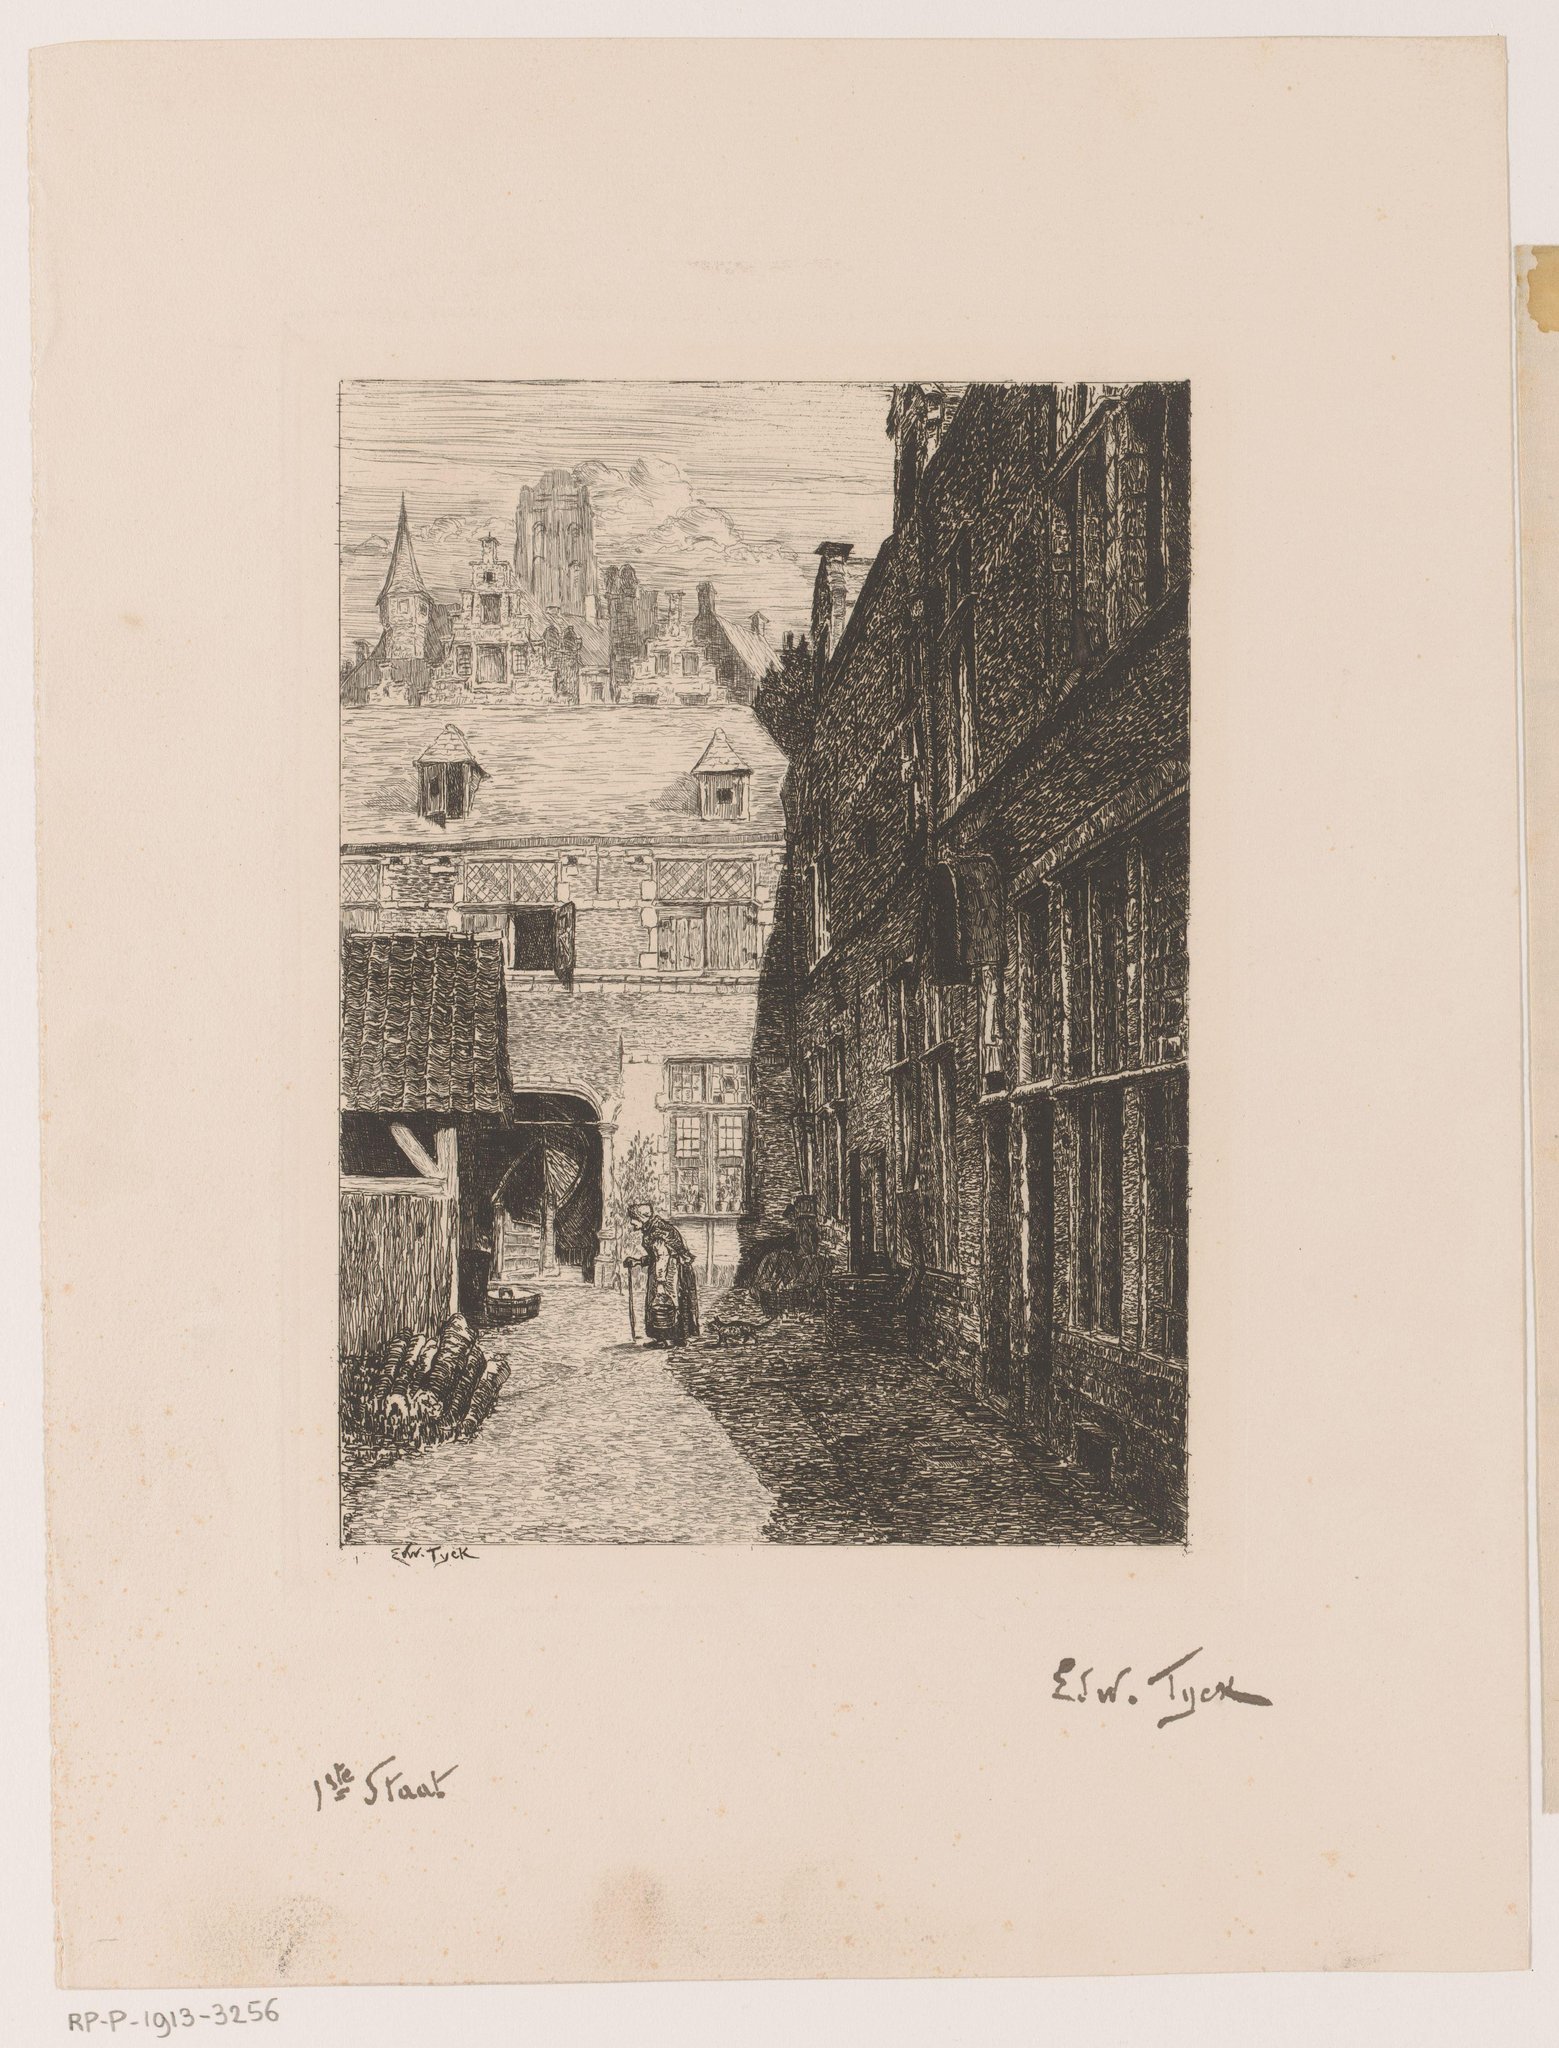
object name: print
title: Straatgezicht met toren van de Sint-Jacobskerk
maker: edouard tyck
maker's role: print maker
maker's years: 1847-1922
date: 1880-1913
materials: paper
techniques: drypoint, etching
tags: city-view in general; 'veduta', parts of church exterior and annexes: tower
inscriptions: collector's mark: Lugt 2228